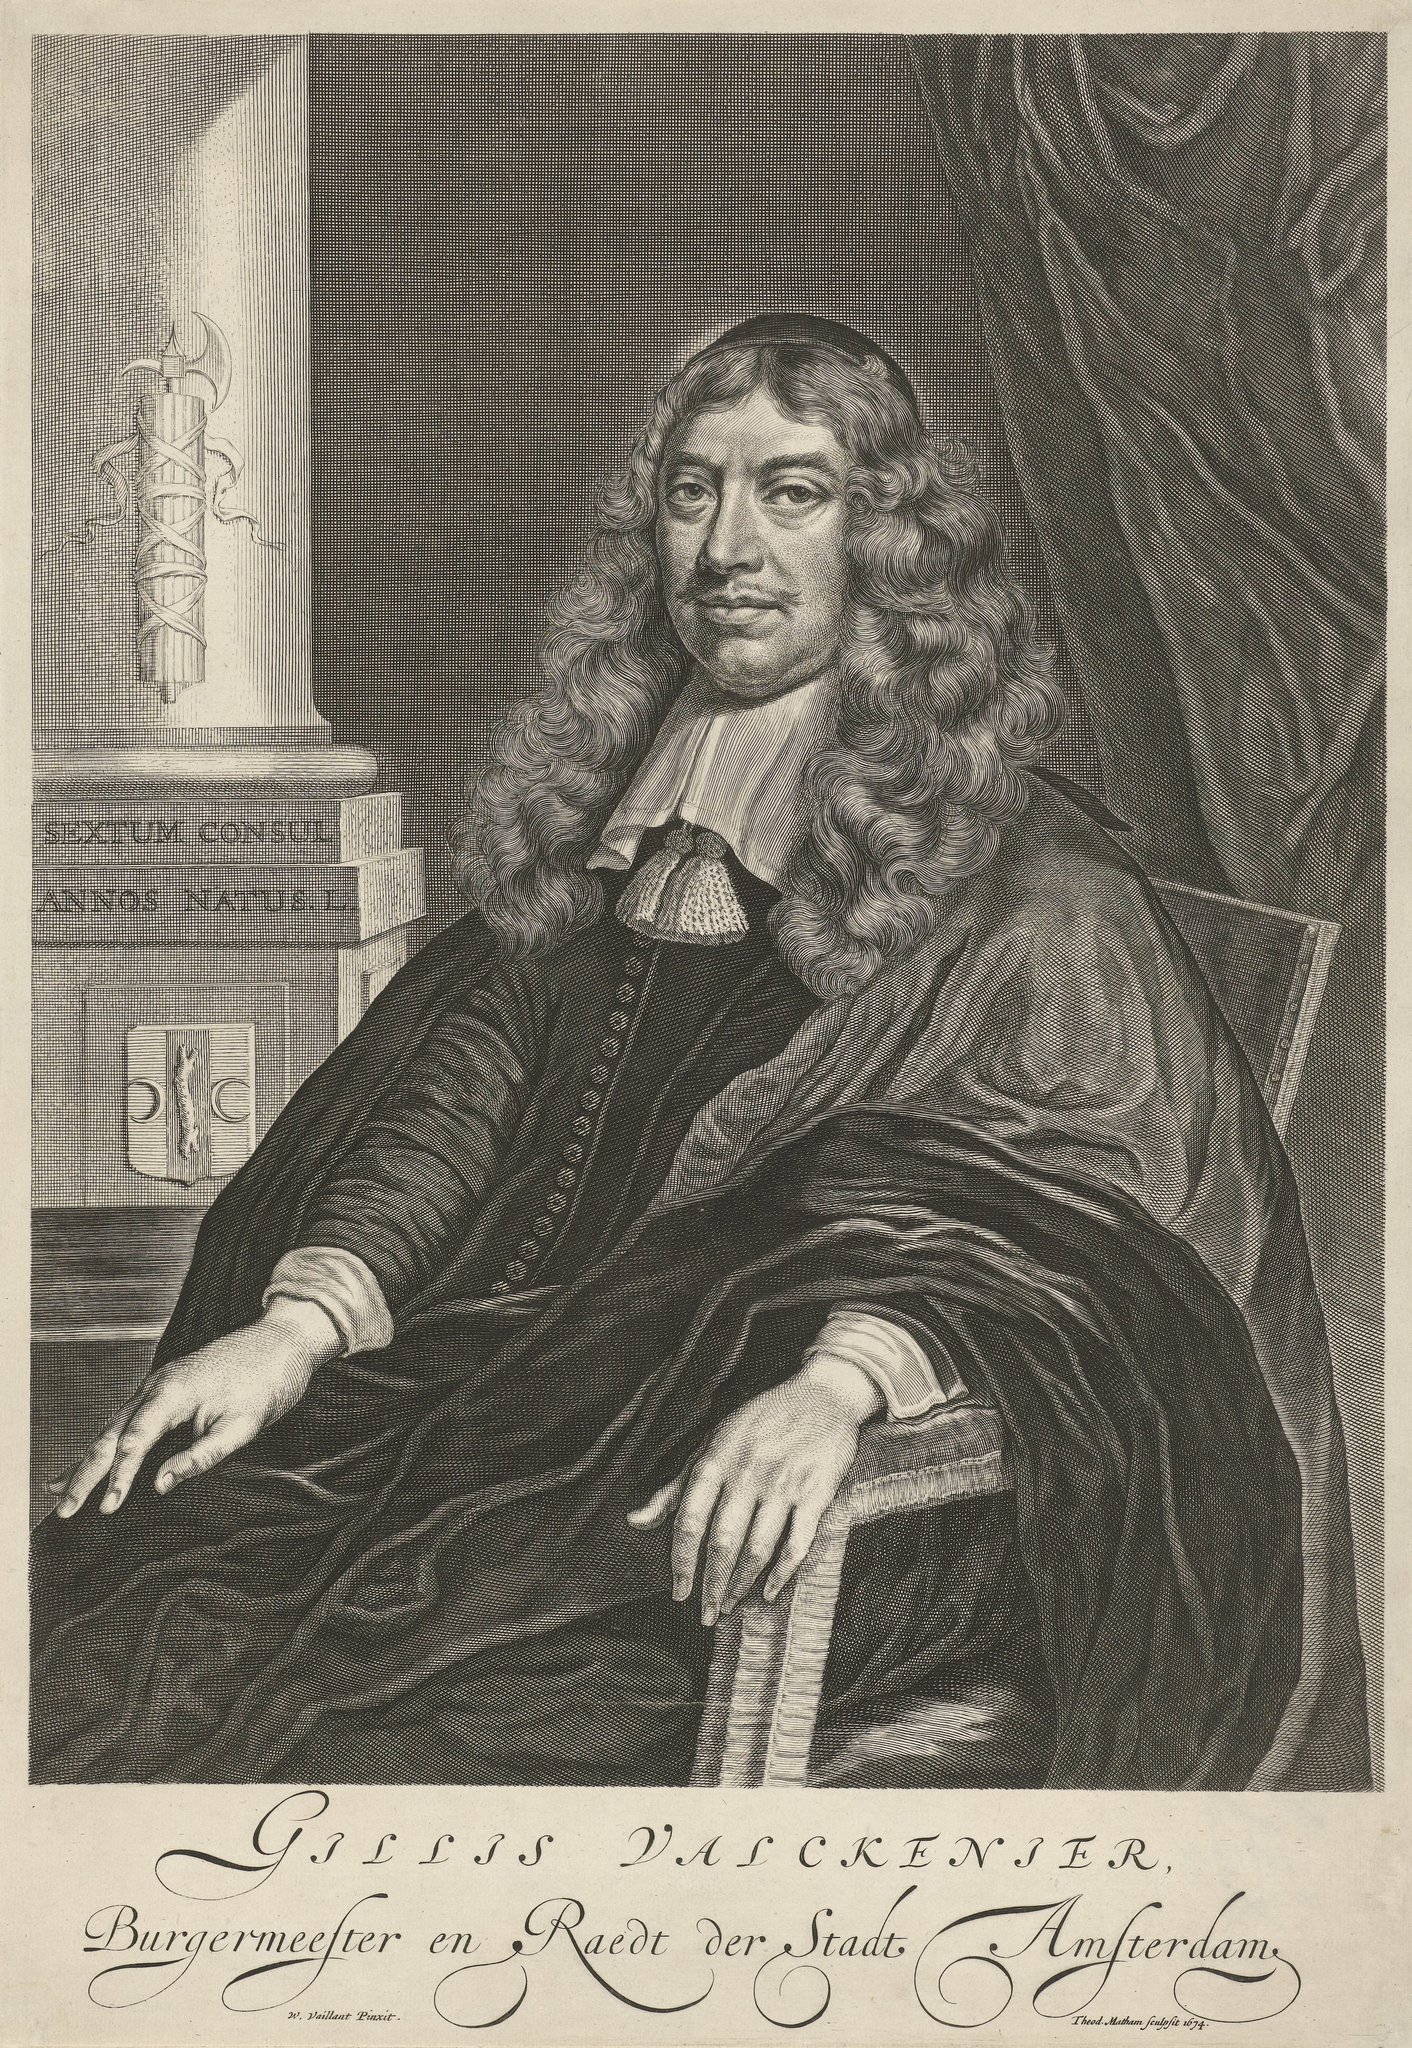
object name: print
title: Portret van Gillis Valckenier op 50-jarige leeftijd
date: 1674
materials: paper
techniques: engraving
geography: amsterdam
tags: historical persons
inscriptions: collector's mark: Lugt 1120, collector's mark: Lugt 2228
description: Portret van Gillis Valckenier, burgemeester van Amsterdam, op 50-jarige leeftijd.